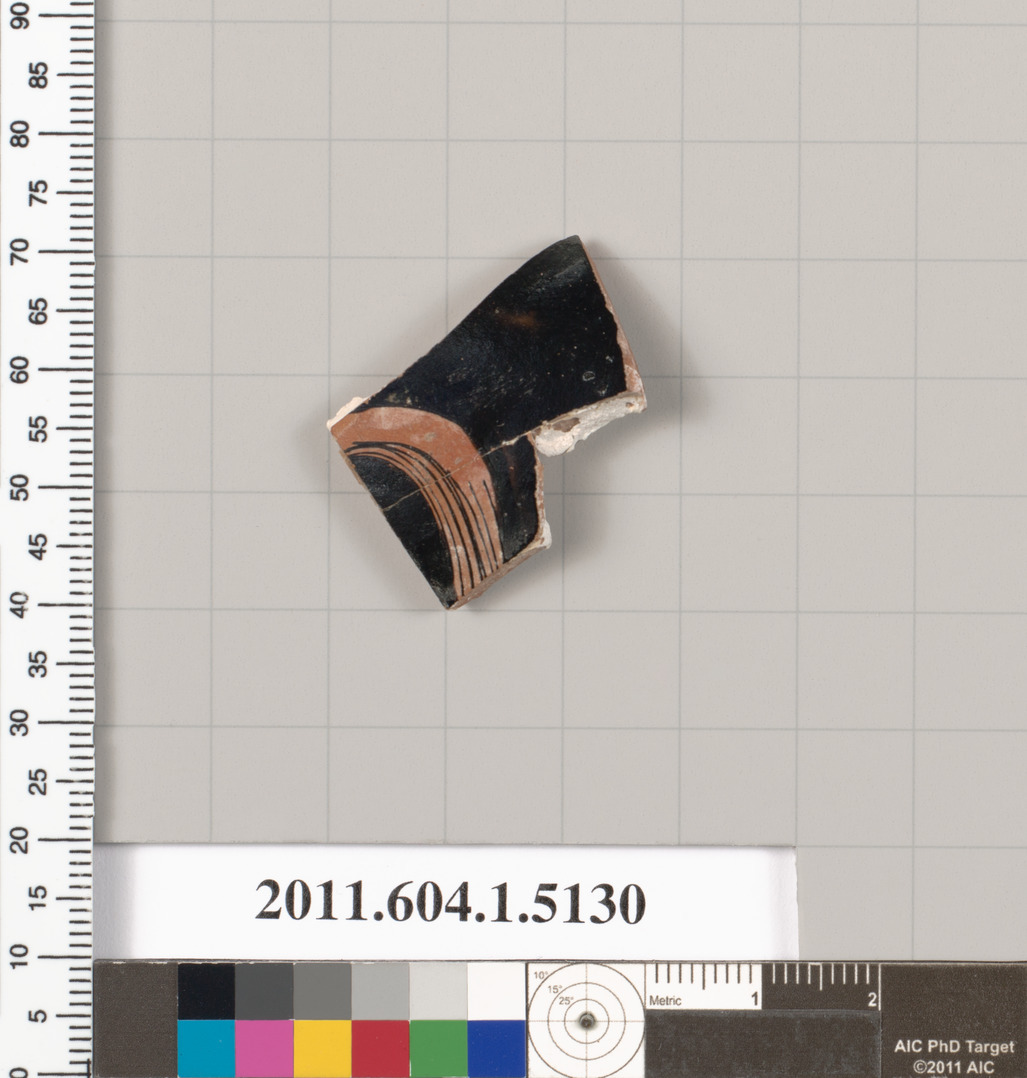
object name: kylix fragment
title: Terracotta fragment of a kylix (drinking cup)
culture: greek, attic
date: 490-480 BCE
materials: terracotta